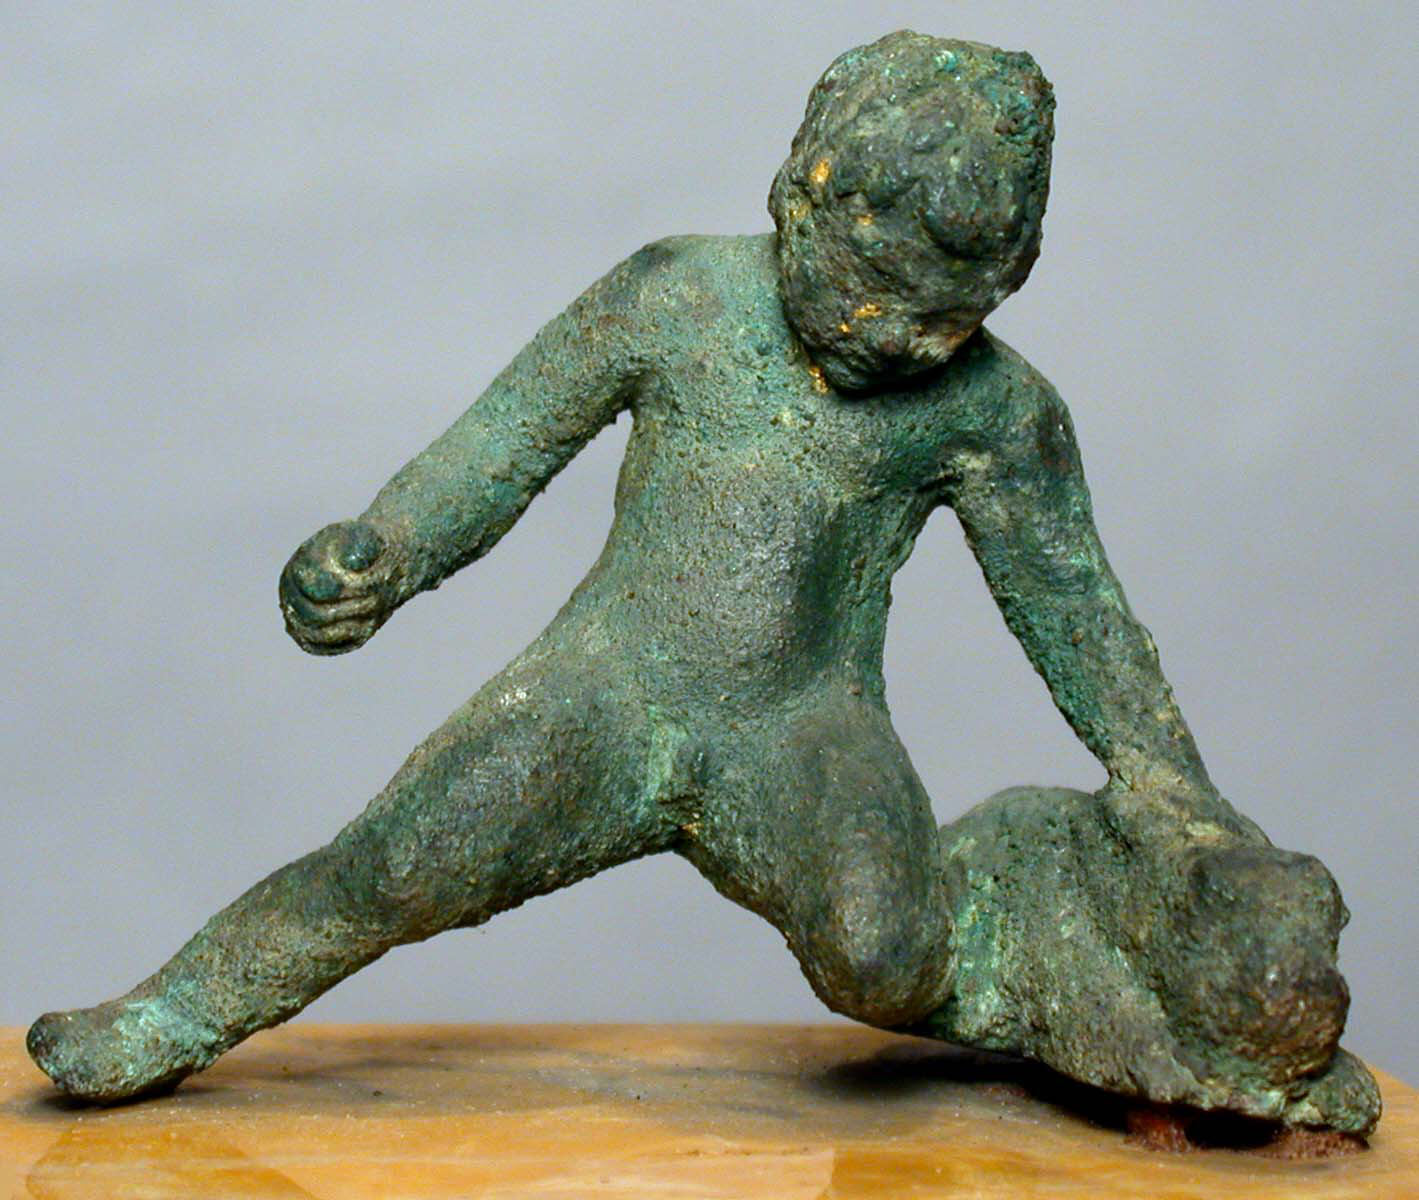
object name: statuette of a kneeling boy holding a hare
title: Bronze statuette of a kneeling boy holding a hare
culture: greek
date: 300-101 BCE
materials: bronze